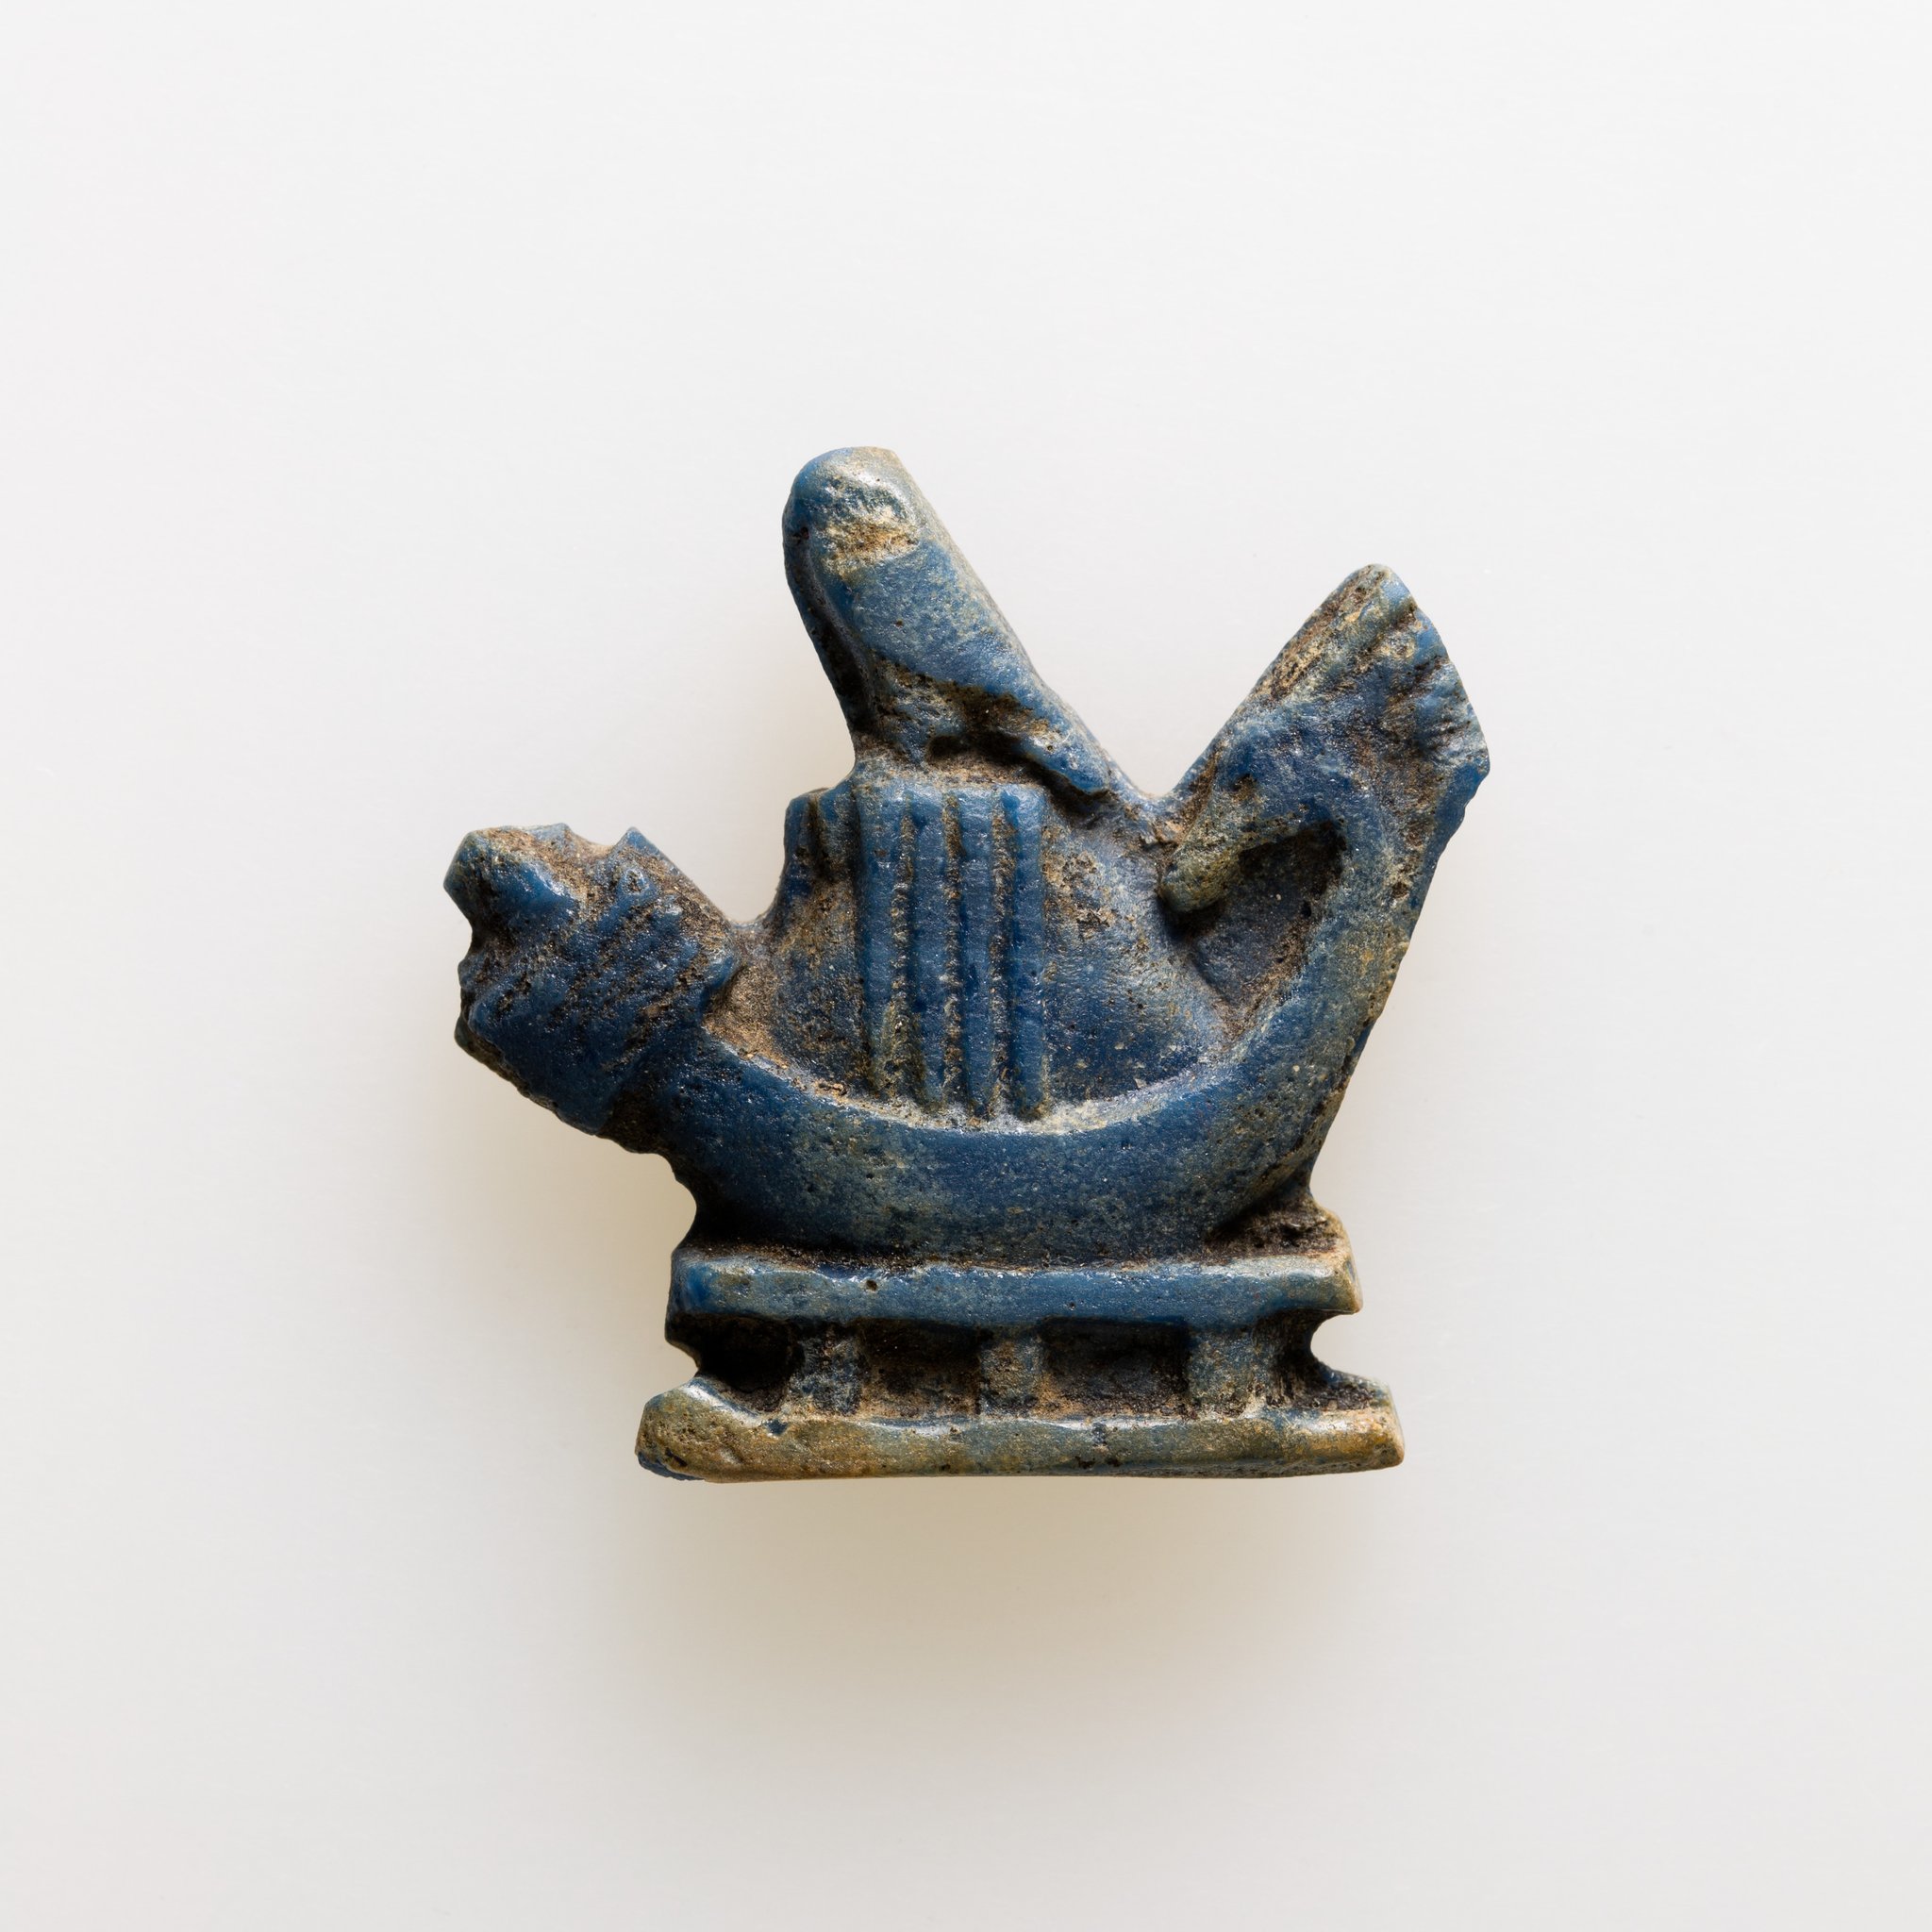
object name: amulet, henu barque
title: Henu barque amulet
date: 525-30 BCE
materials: glass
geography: egypt